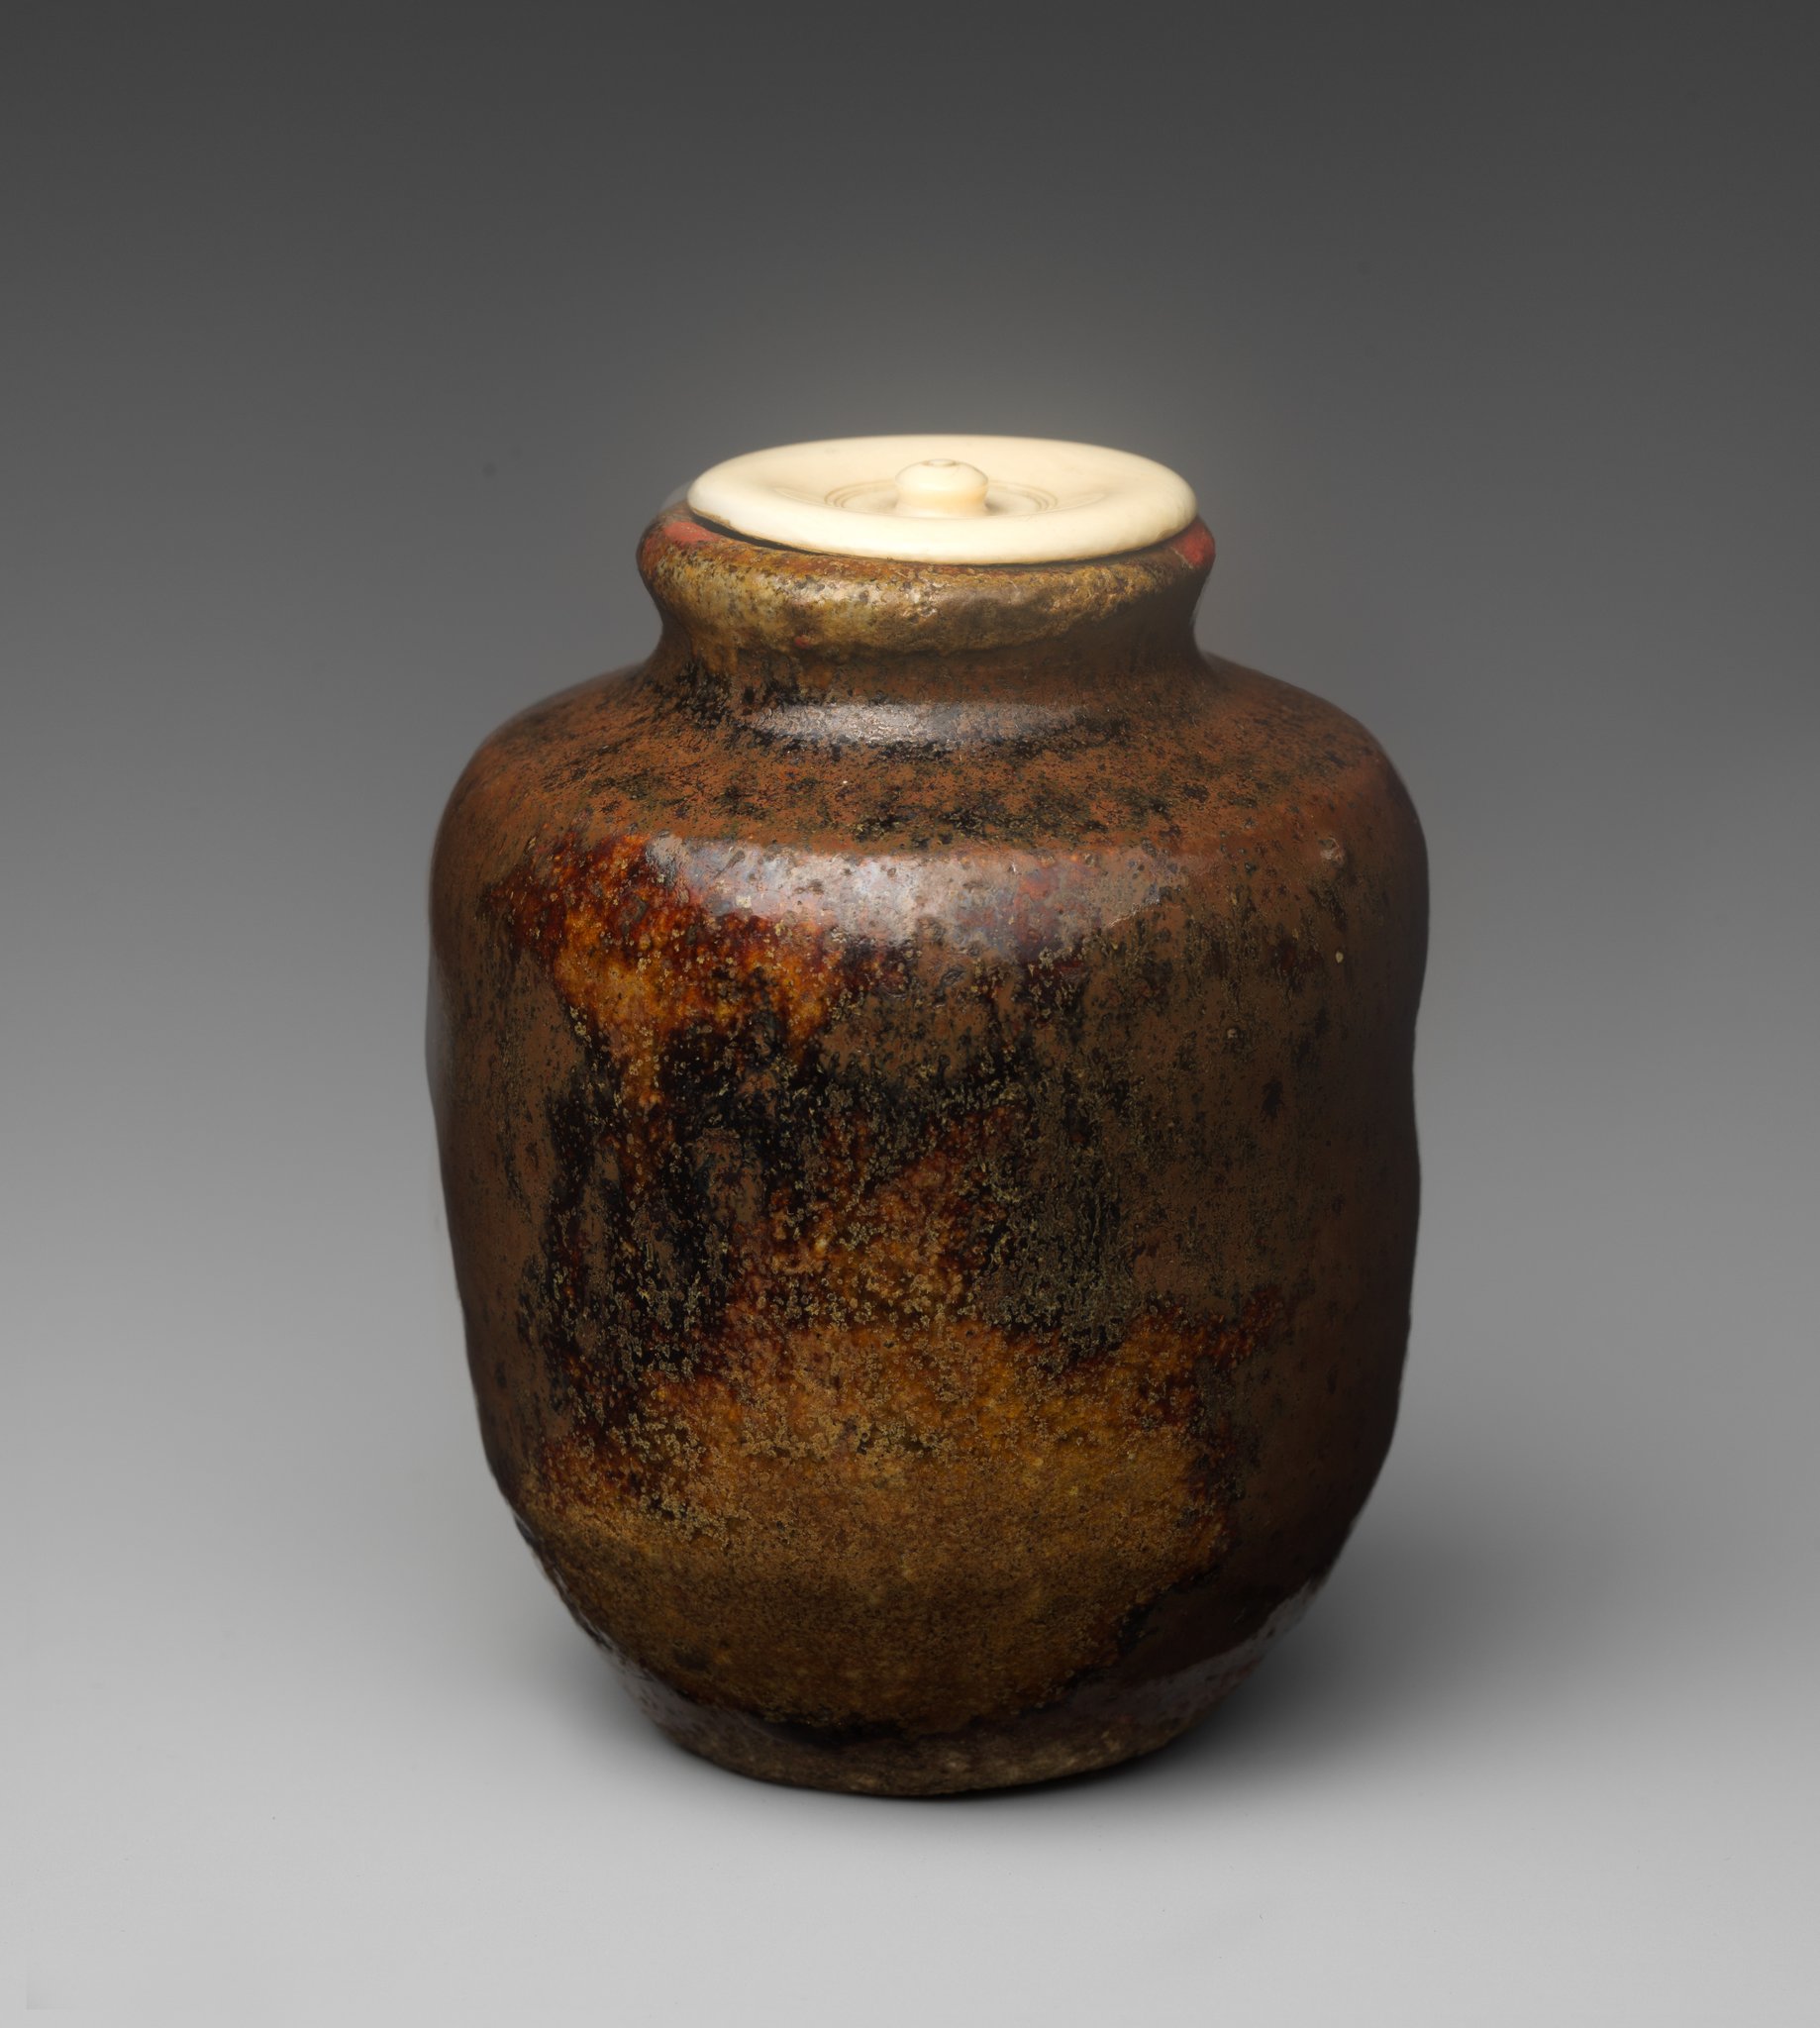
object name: tea jar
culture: japanese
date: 1701-1800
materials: clay, glaze